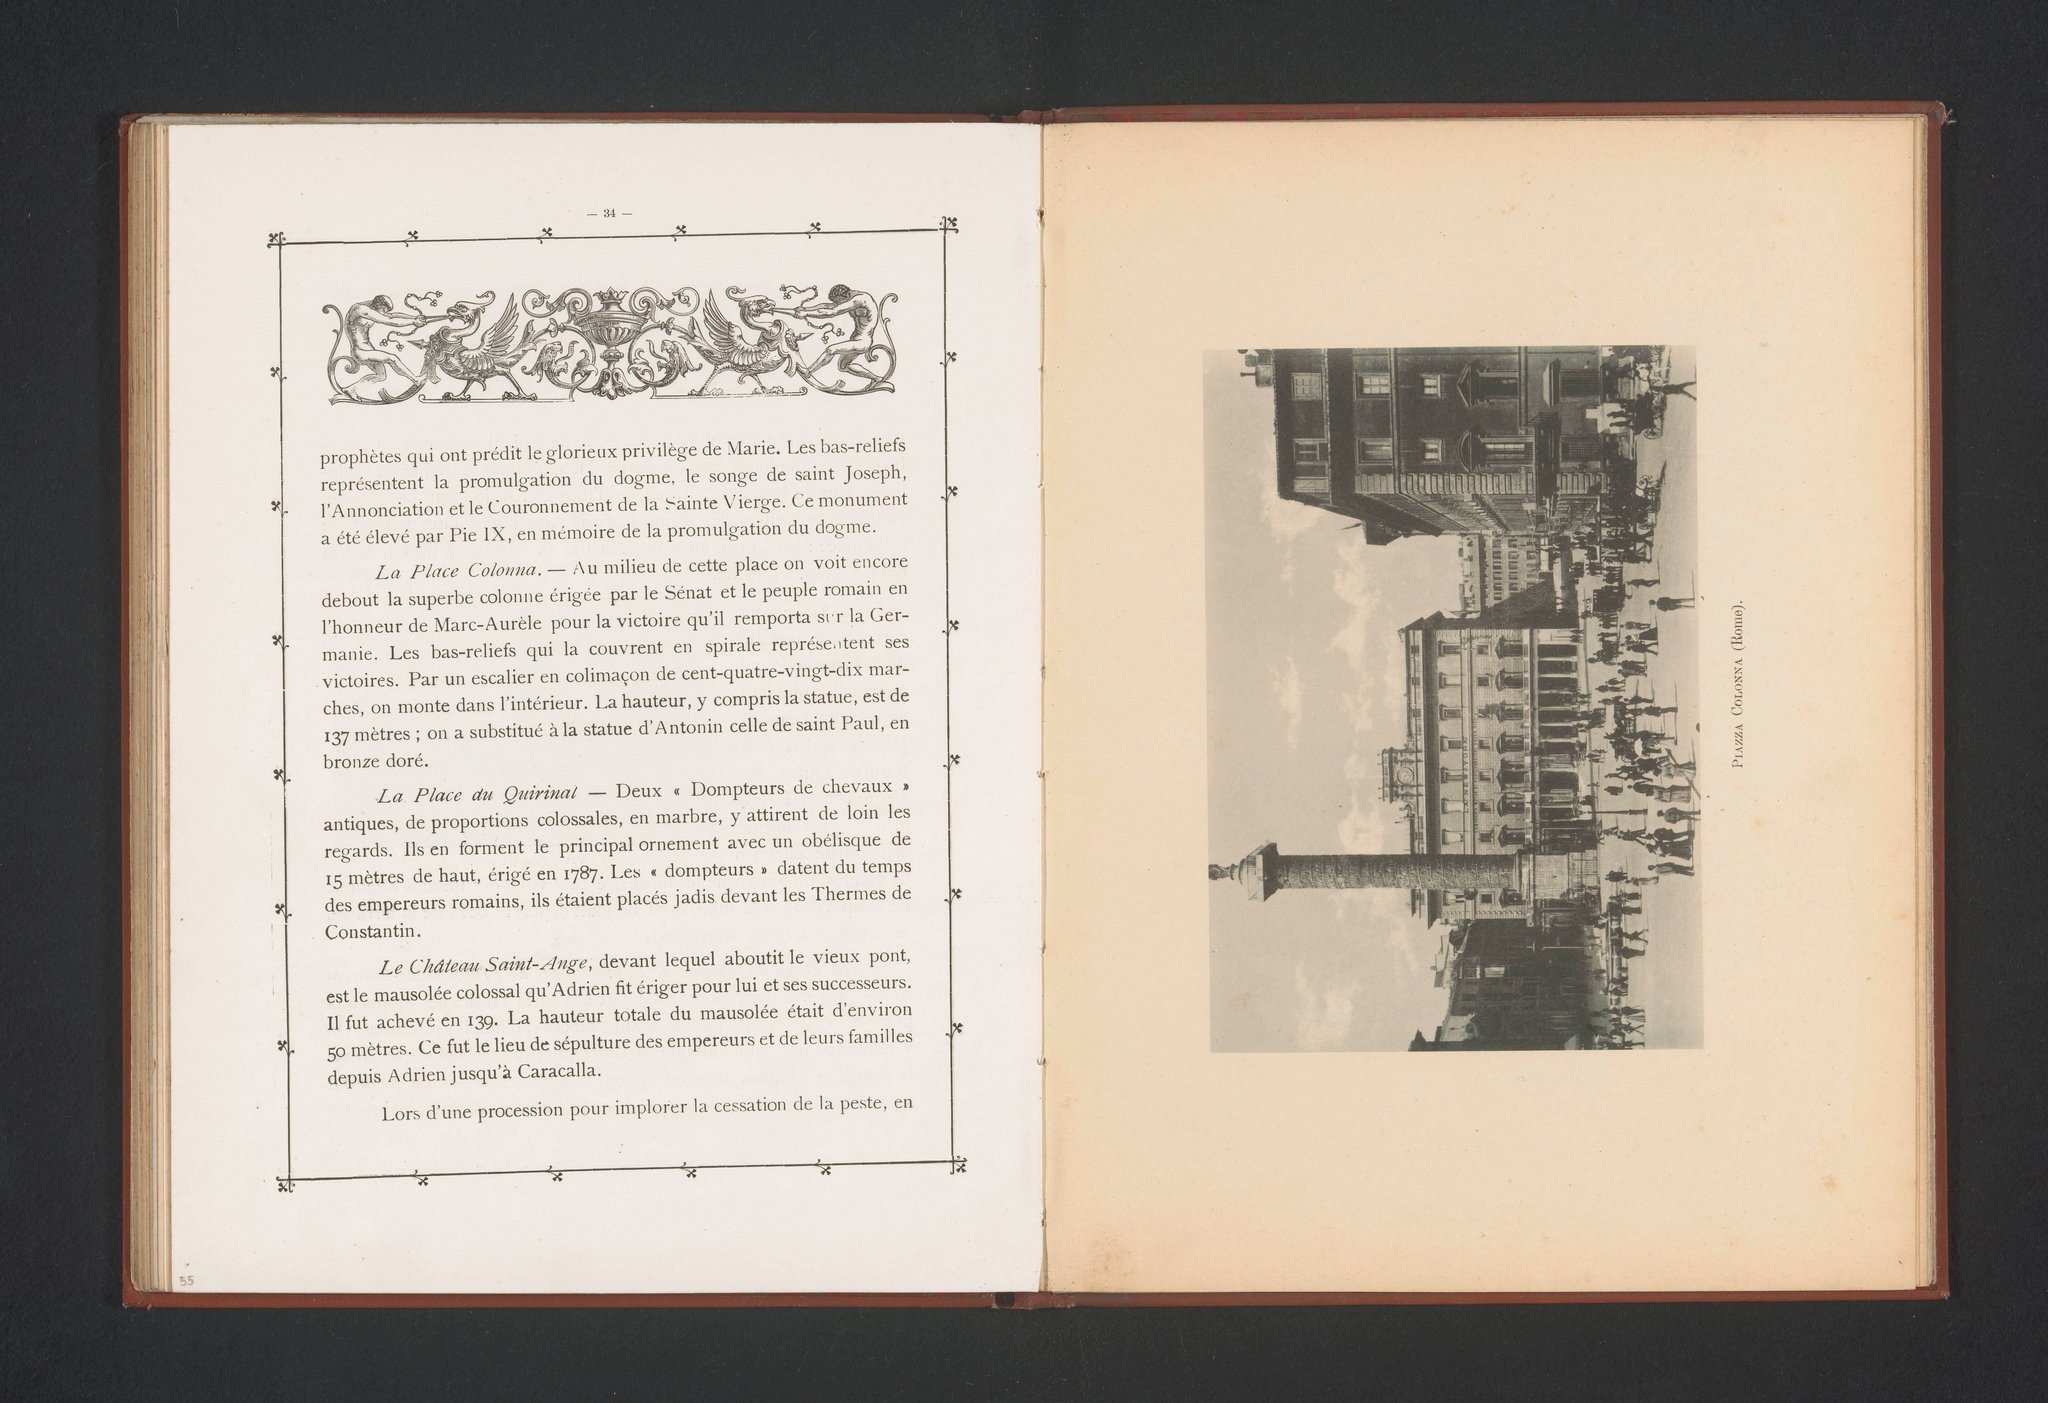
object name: page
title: Piazza Colonna (Rome)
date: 1893-1898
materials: paper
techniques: photograph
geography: piazza colonna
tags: square, place, circus, etc., triumphal column with helical friezes, (story of) marcus aurelius, the roman emperor